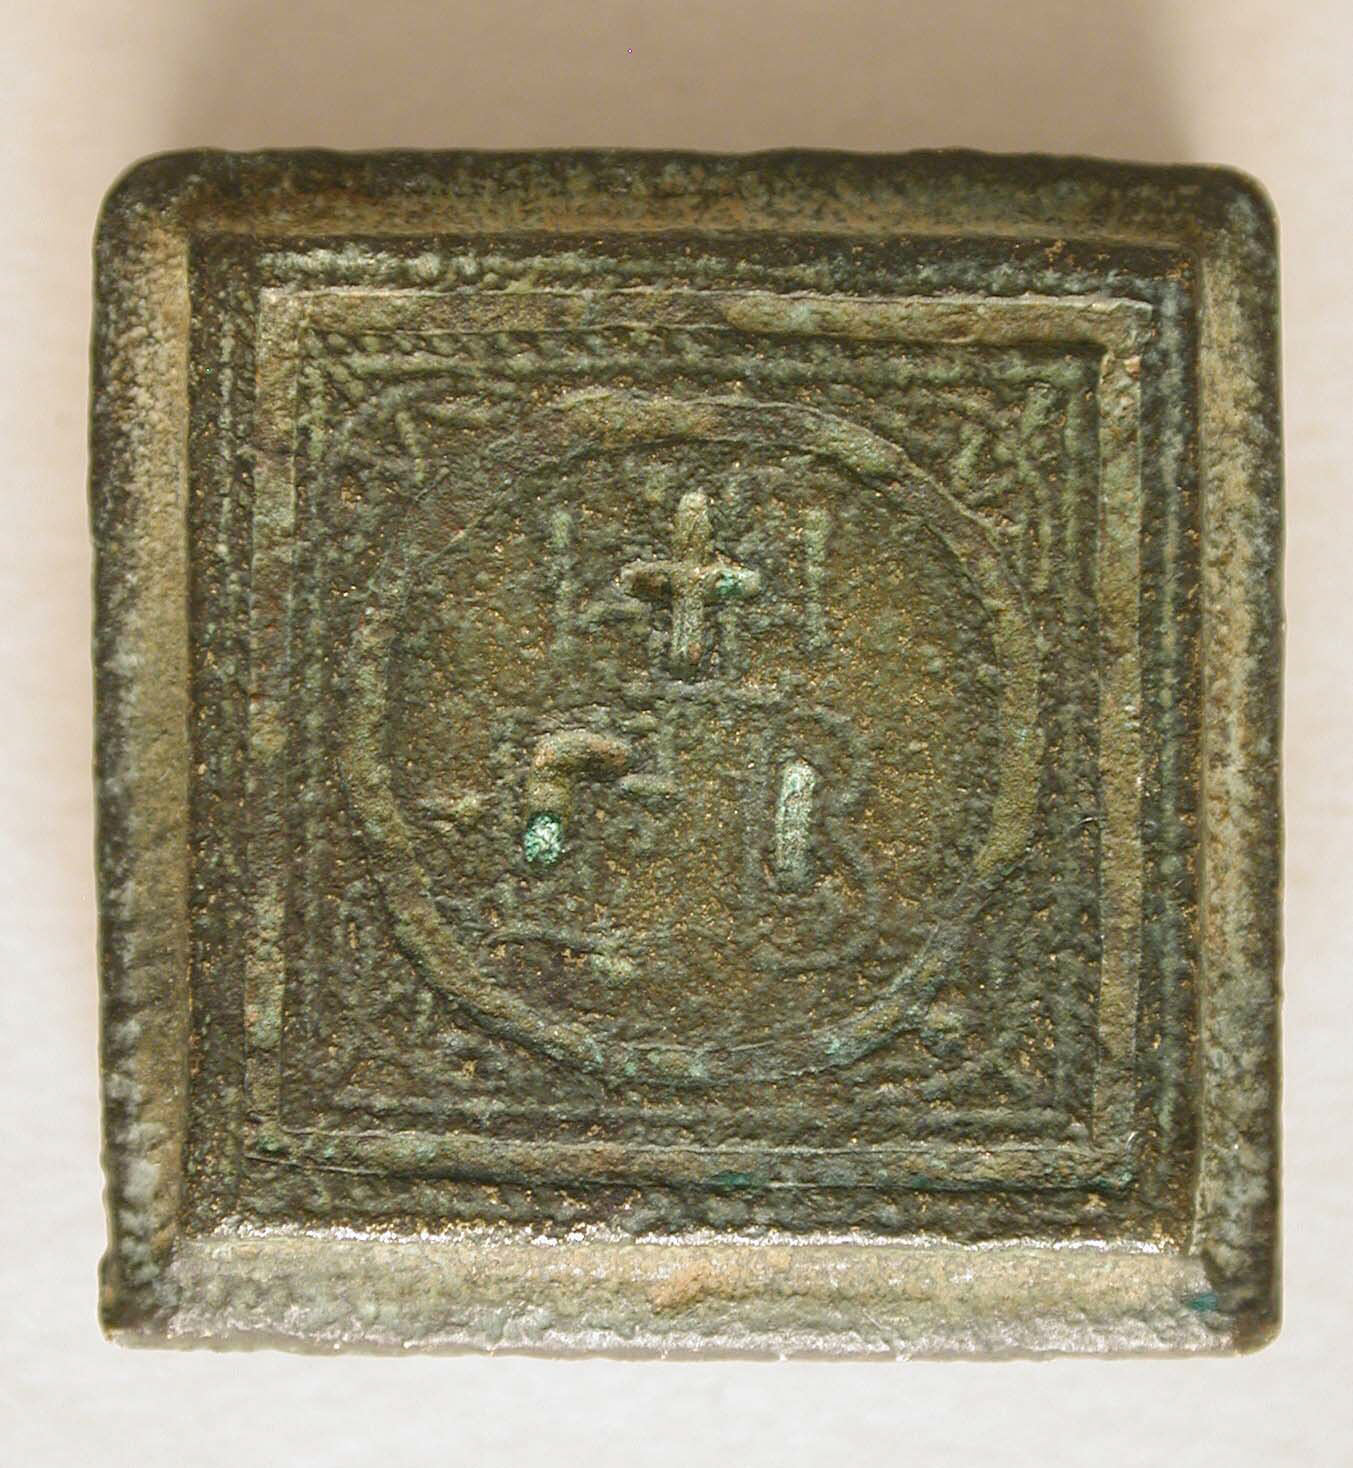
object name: weight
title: Copper-Alloy Balance Weight with Cross in a Circular Border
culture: byzantine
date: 401-600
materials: copper alloy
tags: cross